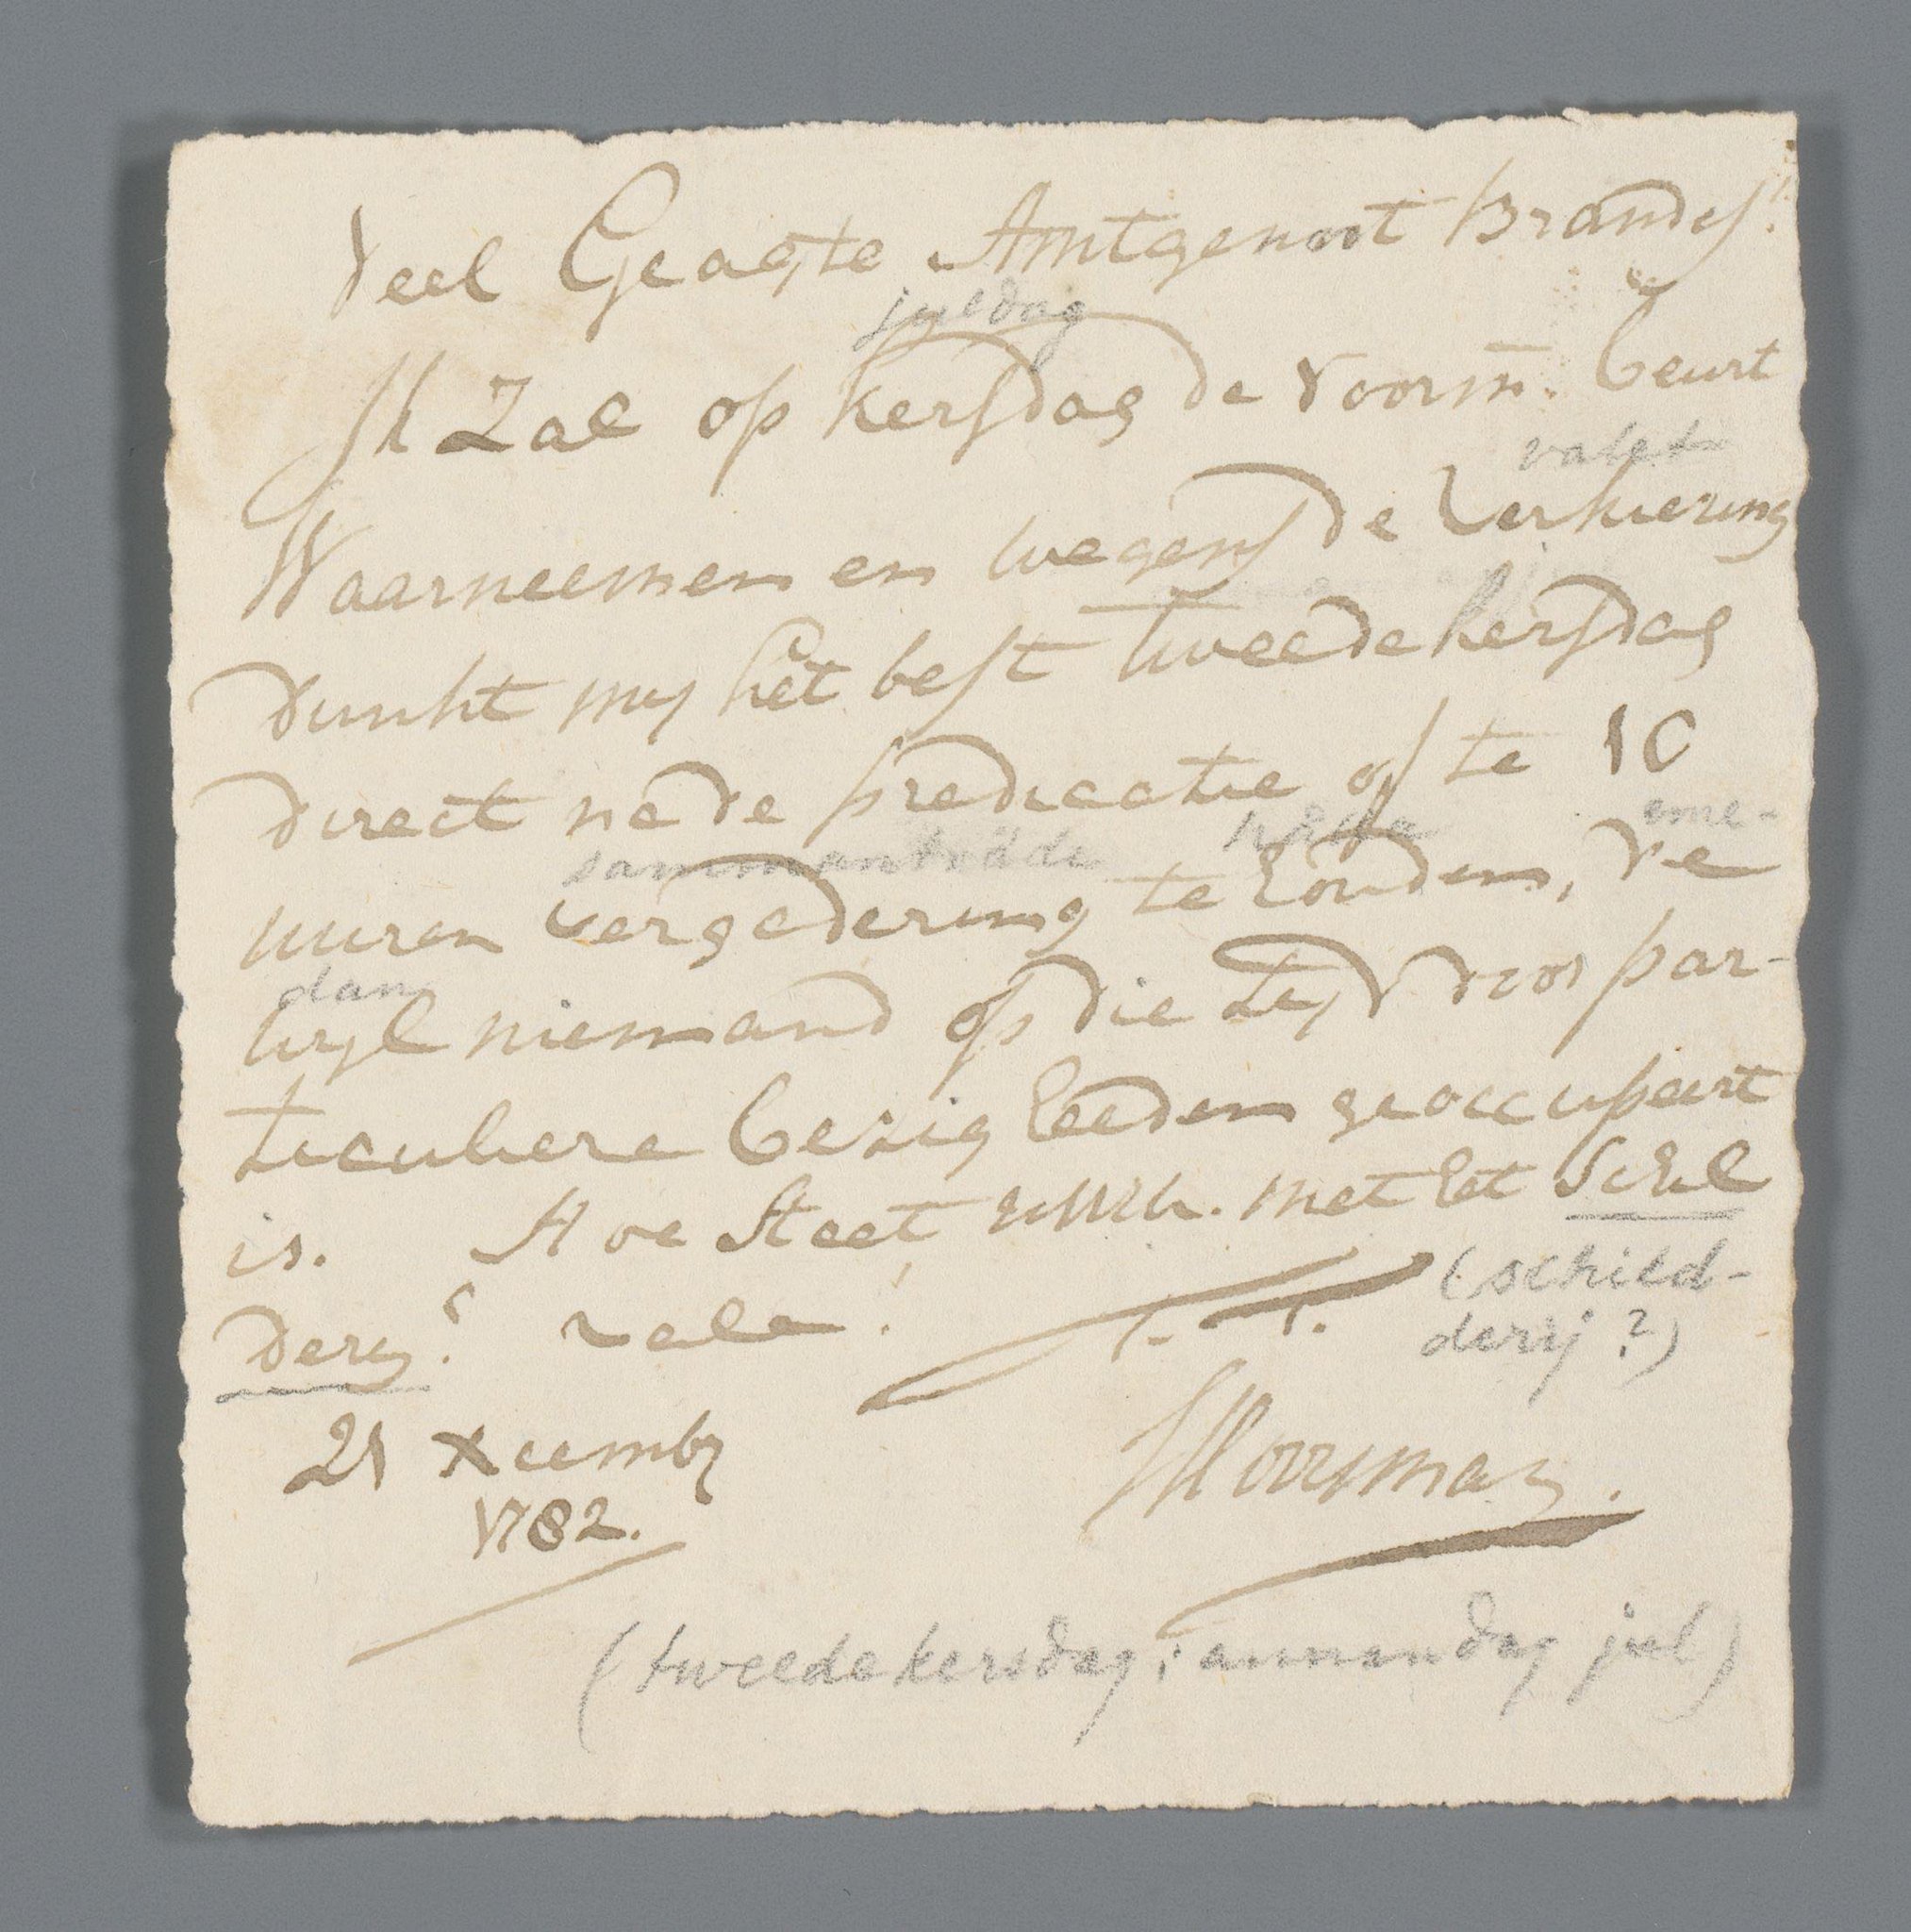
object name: document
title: Briefje over het waarnemen van een preekbeurt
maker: johannes hooyman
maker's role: predikant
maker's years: -1789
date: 1782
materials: ink, paper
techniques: pen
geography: batavia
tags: bodegraven, draughtsman, jan brandes, batavia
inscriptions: date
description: Blaadje met een kort briefje van predikant Johannes Hooyman aan Jan Brandes over het waarnemen van diens preekbeurt op tweede kerstdag 1782. In de brief wordt een een schilderij vermeld. Onderdeel van een groep papieren van Jan Brandes uit zijn tijd als predikant bij de lutherse kerk te Batavia 1779-1785.